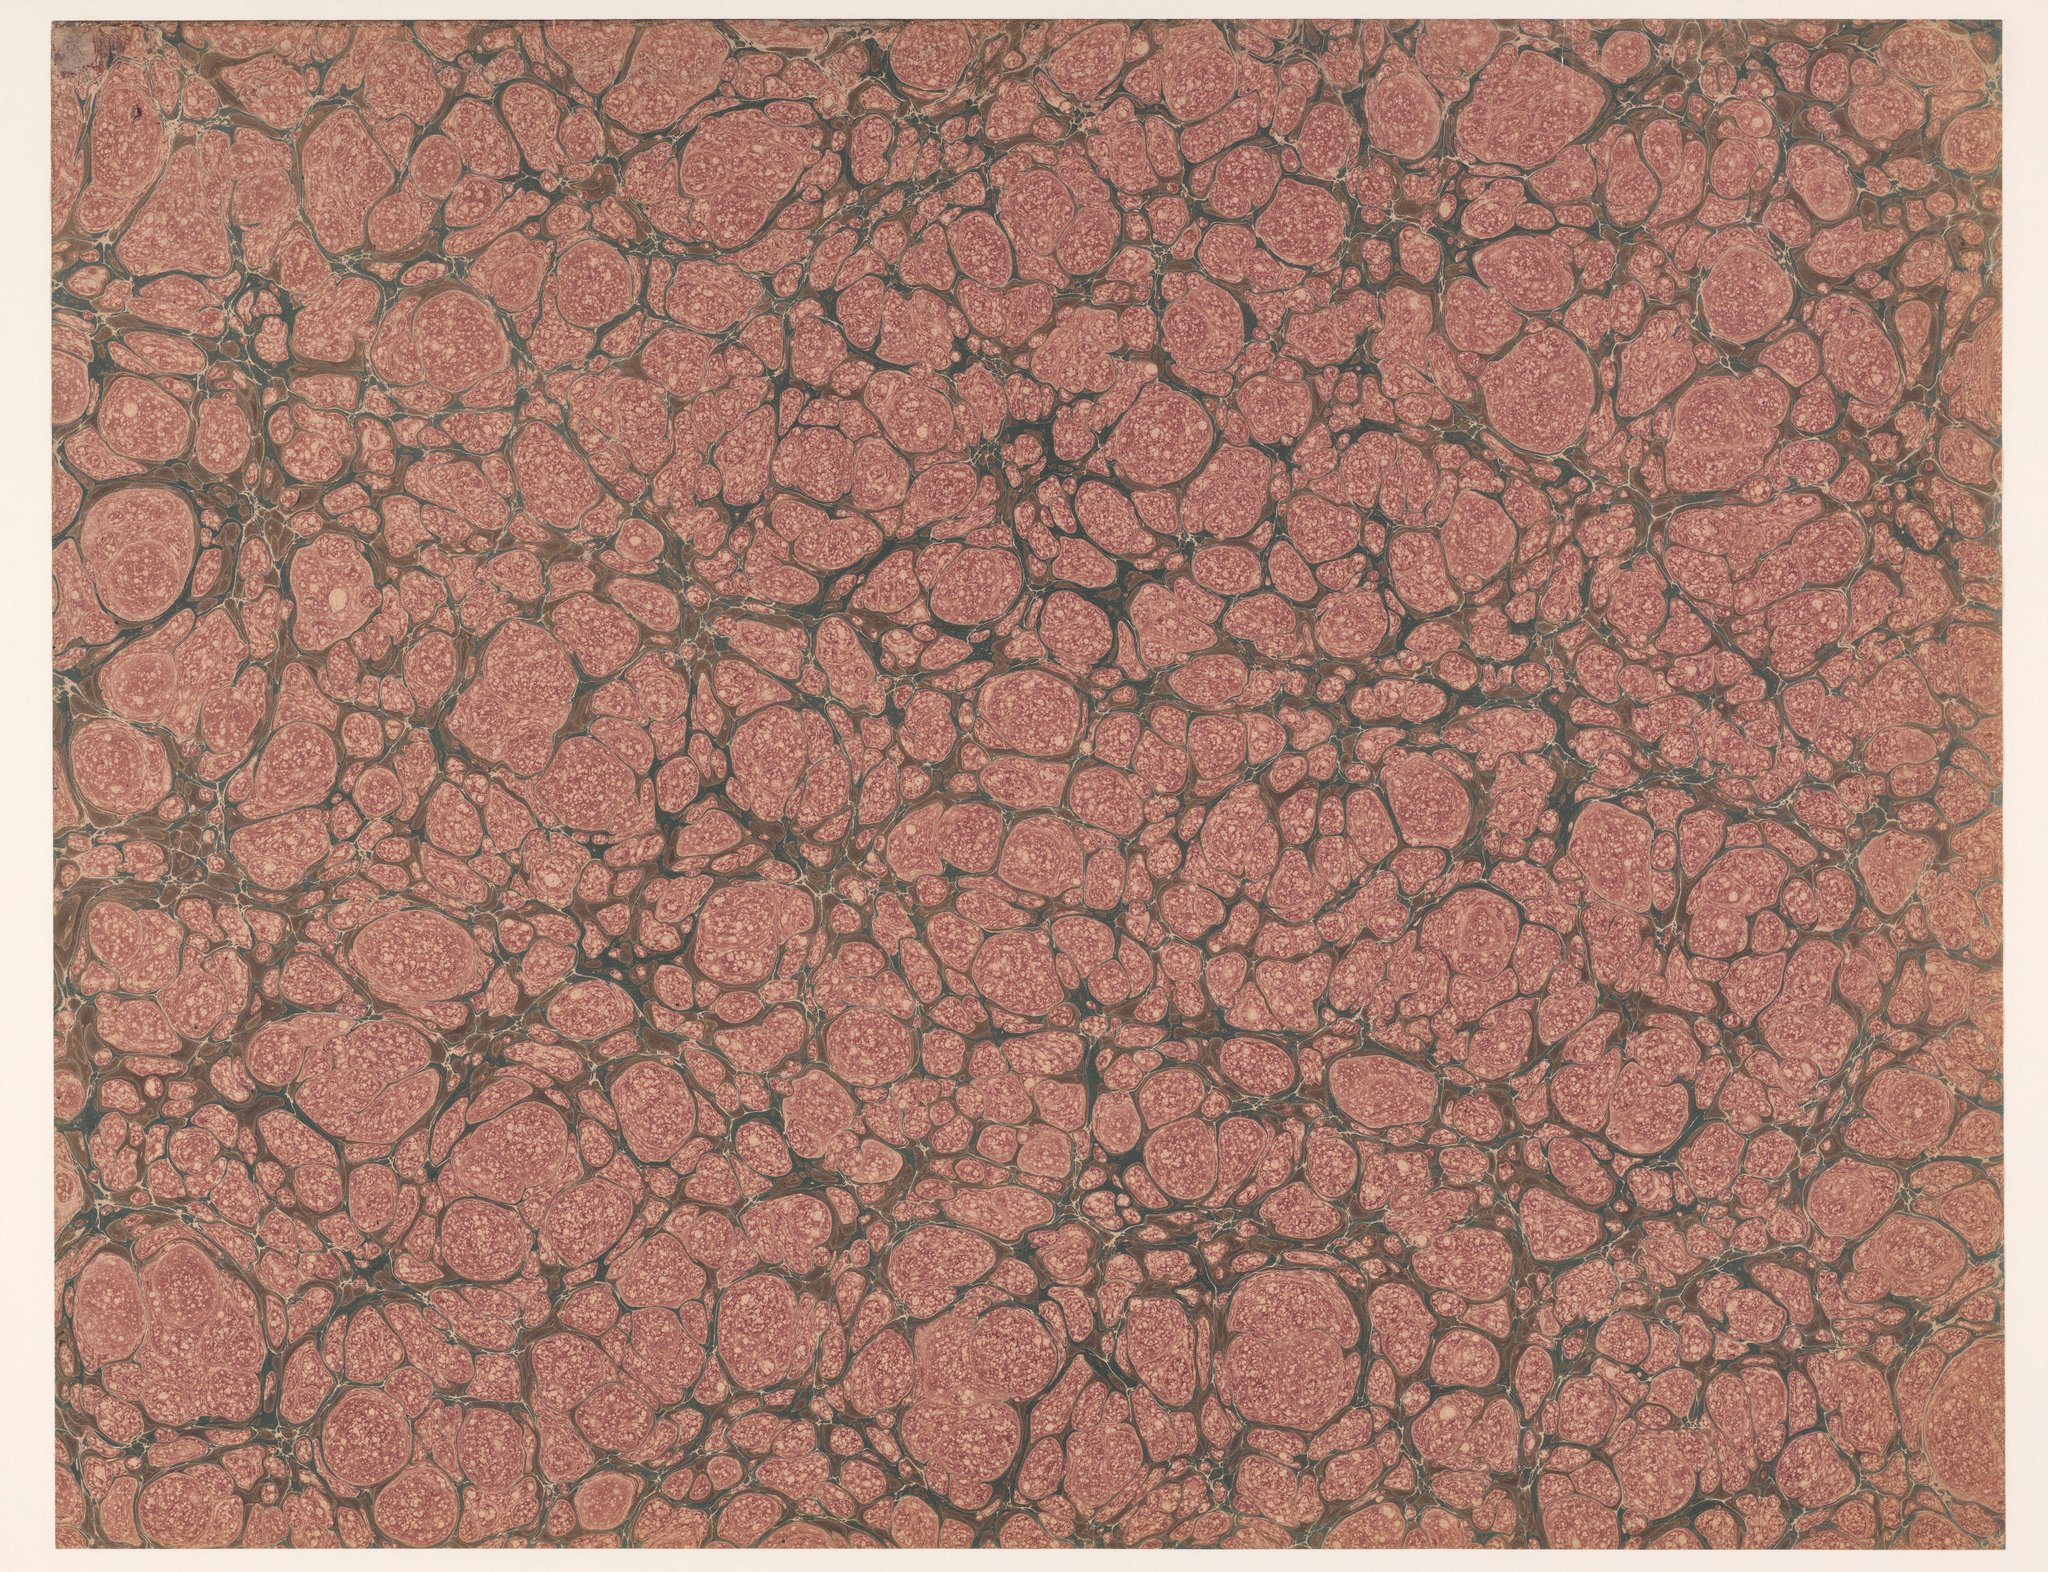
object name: marbled paper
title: Granietmarmer in rood, bruin en blauw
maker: Anonymous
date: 1900-2000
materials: lacquer, paint, paper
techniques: granite marble